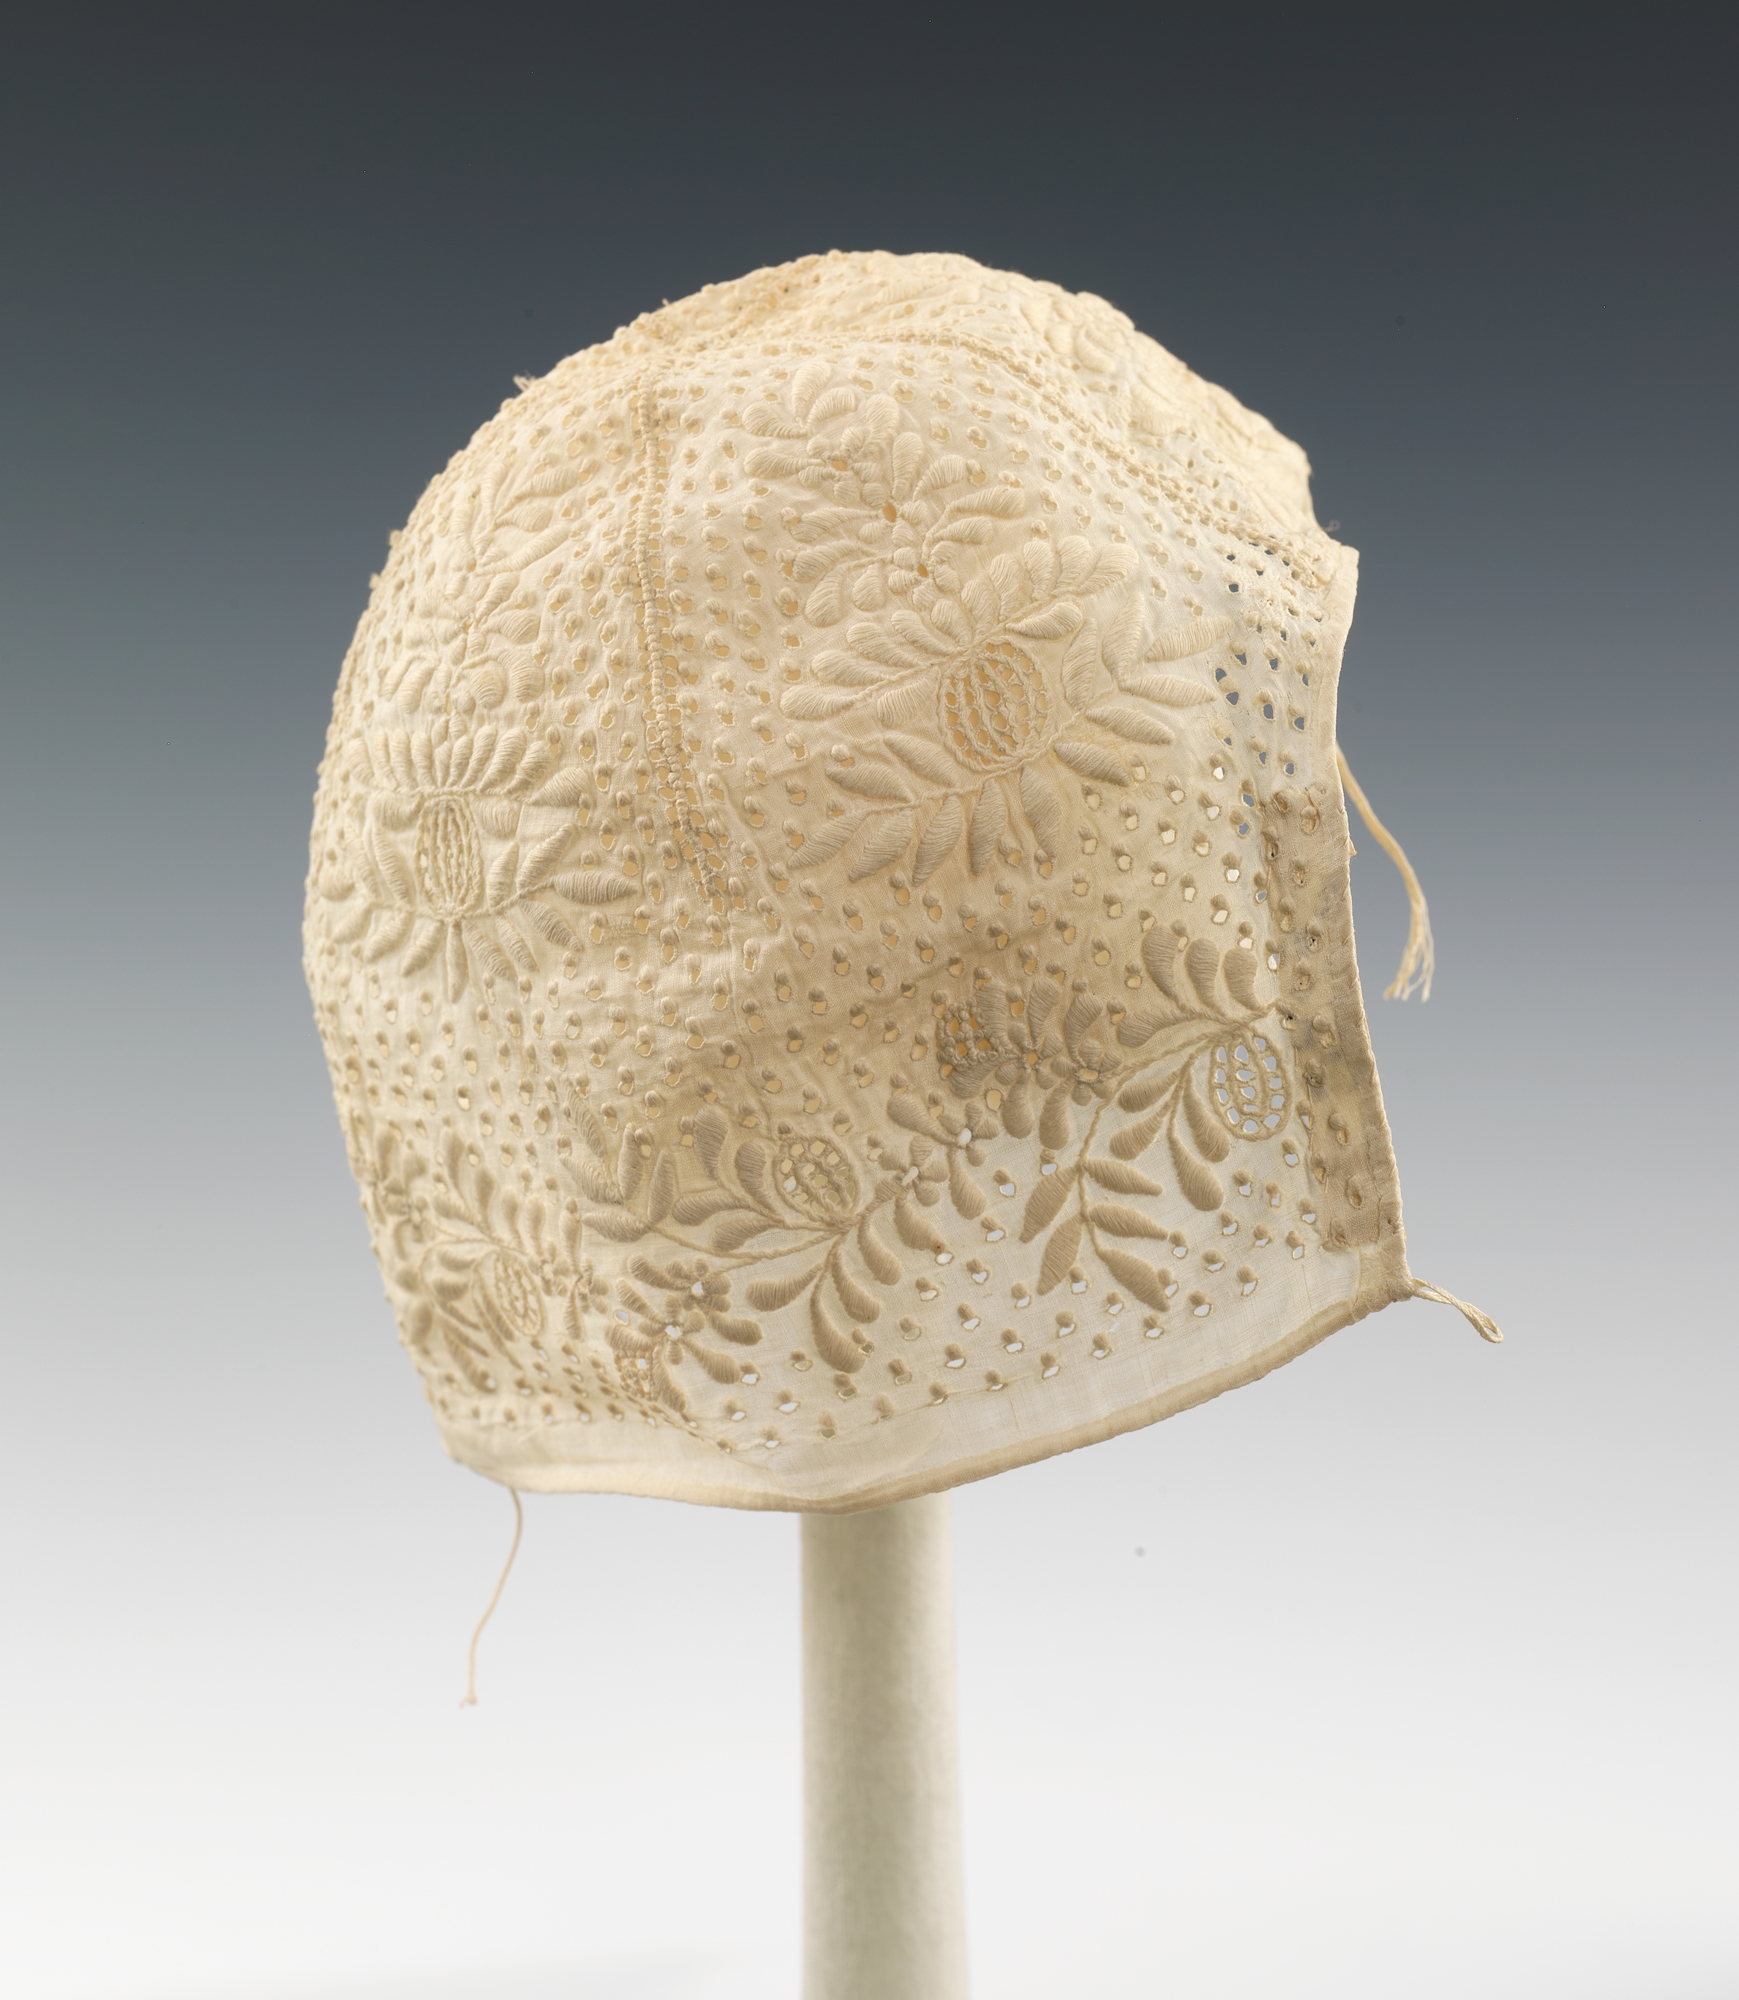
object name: cap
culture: american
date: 1820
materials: linen